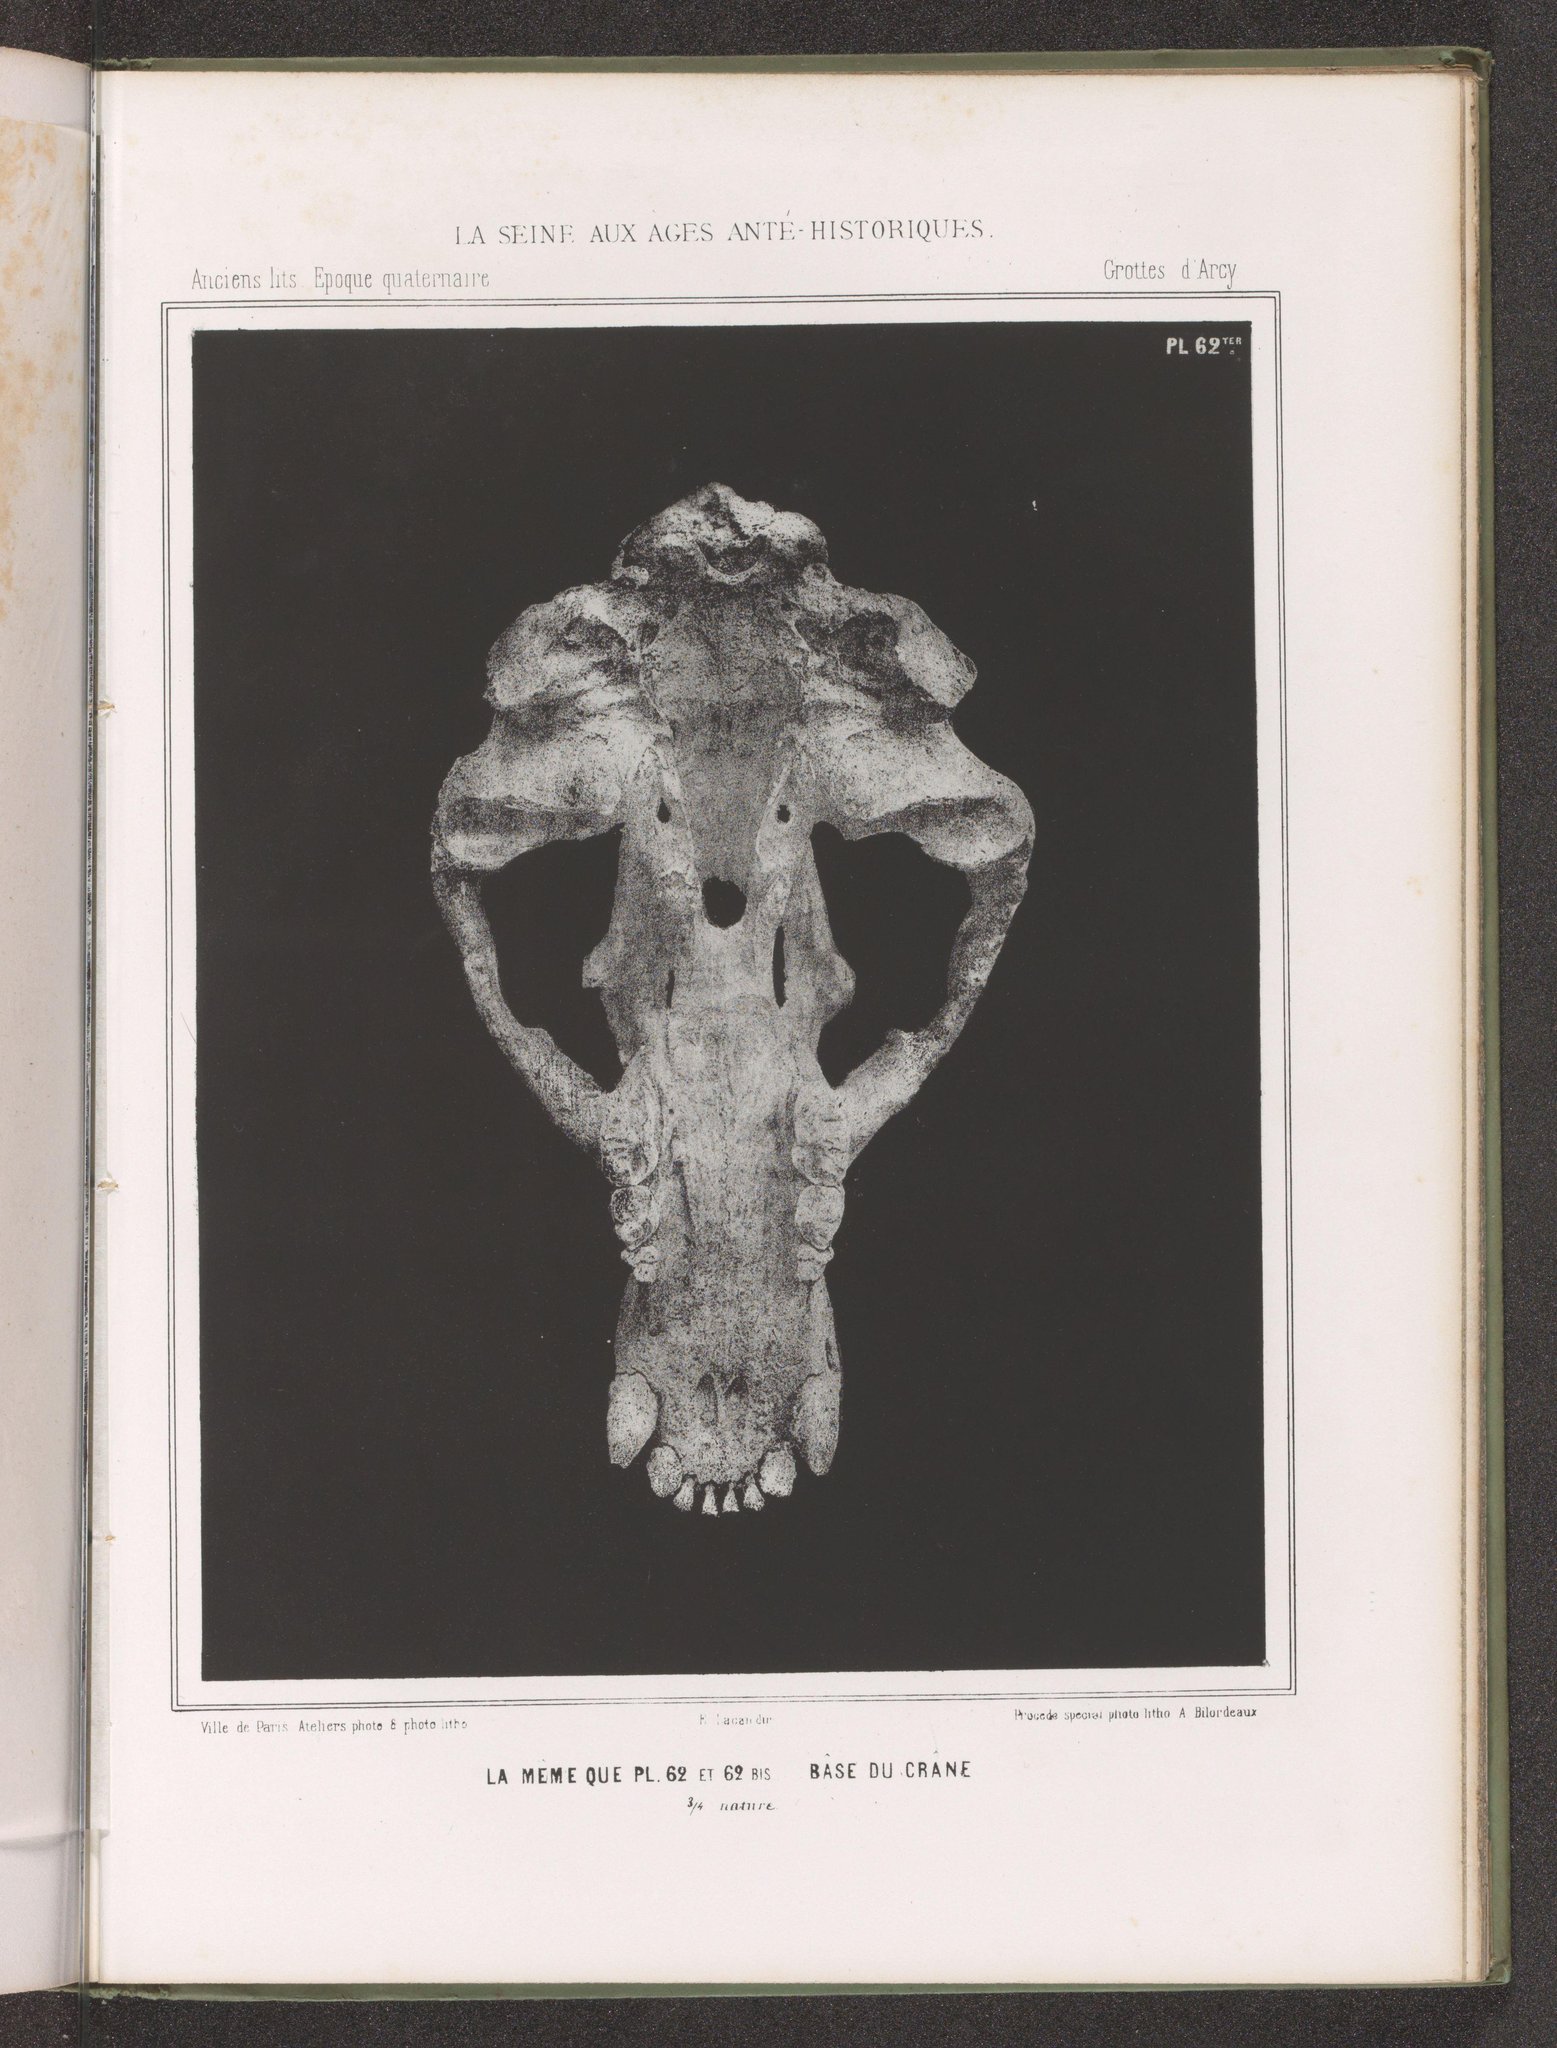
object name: photomechanical print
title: Schedelbasis van een beer, onderaanzicht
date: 1860-1869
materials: paper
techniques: photolithography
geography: paris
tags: animals (+ skeleton of an animal), palaeontology, france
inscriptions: inscription: ‘Ville de Paris. Atelier photo & photo litho E. Lacan, dir Procédé spécial photo-litho A. Bilordeaux’, number: ‘Pl. 62.ter’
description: Voor plek prent in boek: zie nummer onder 'Opschriften / Merken'.